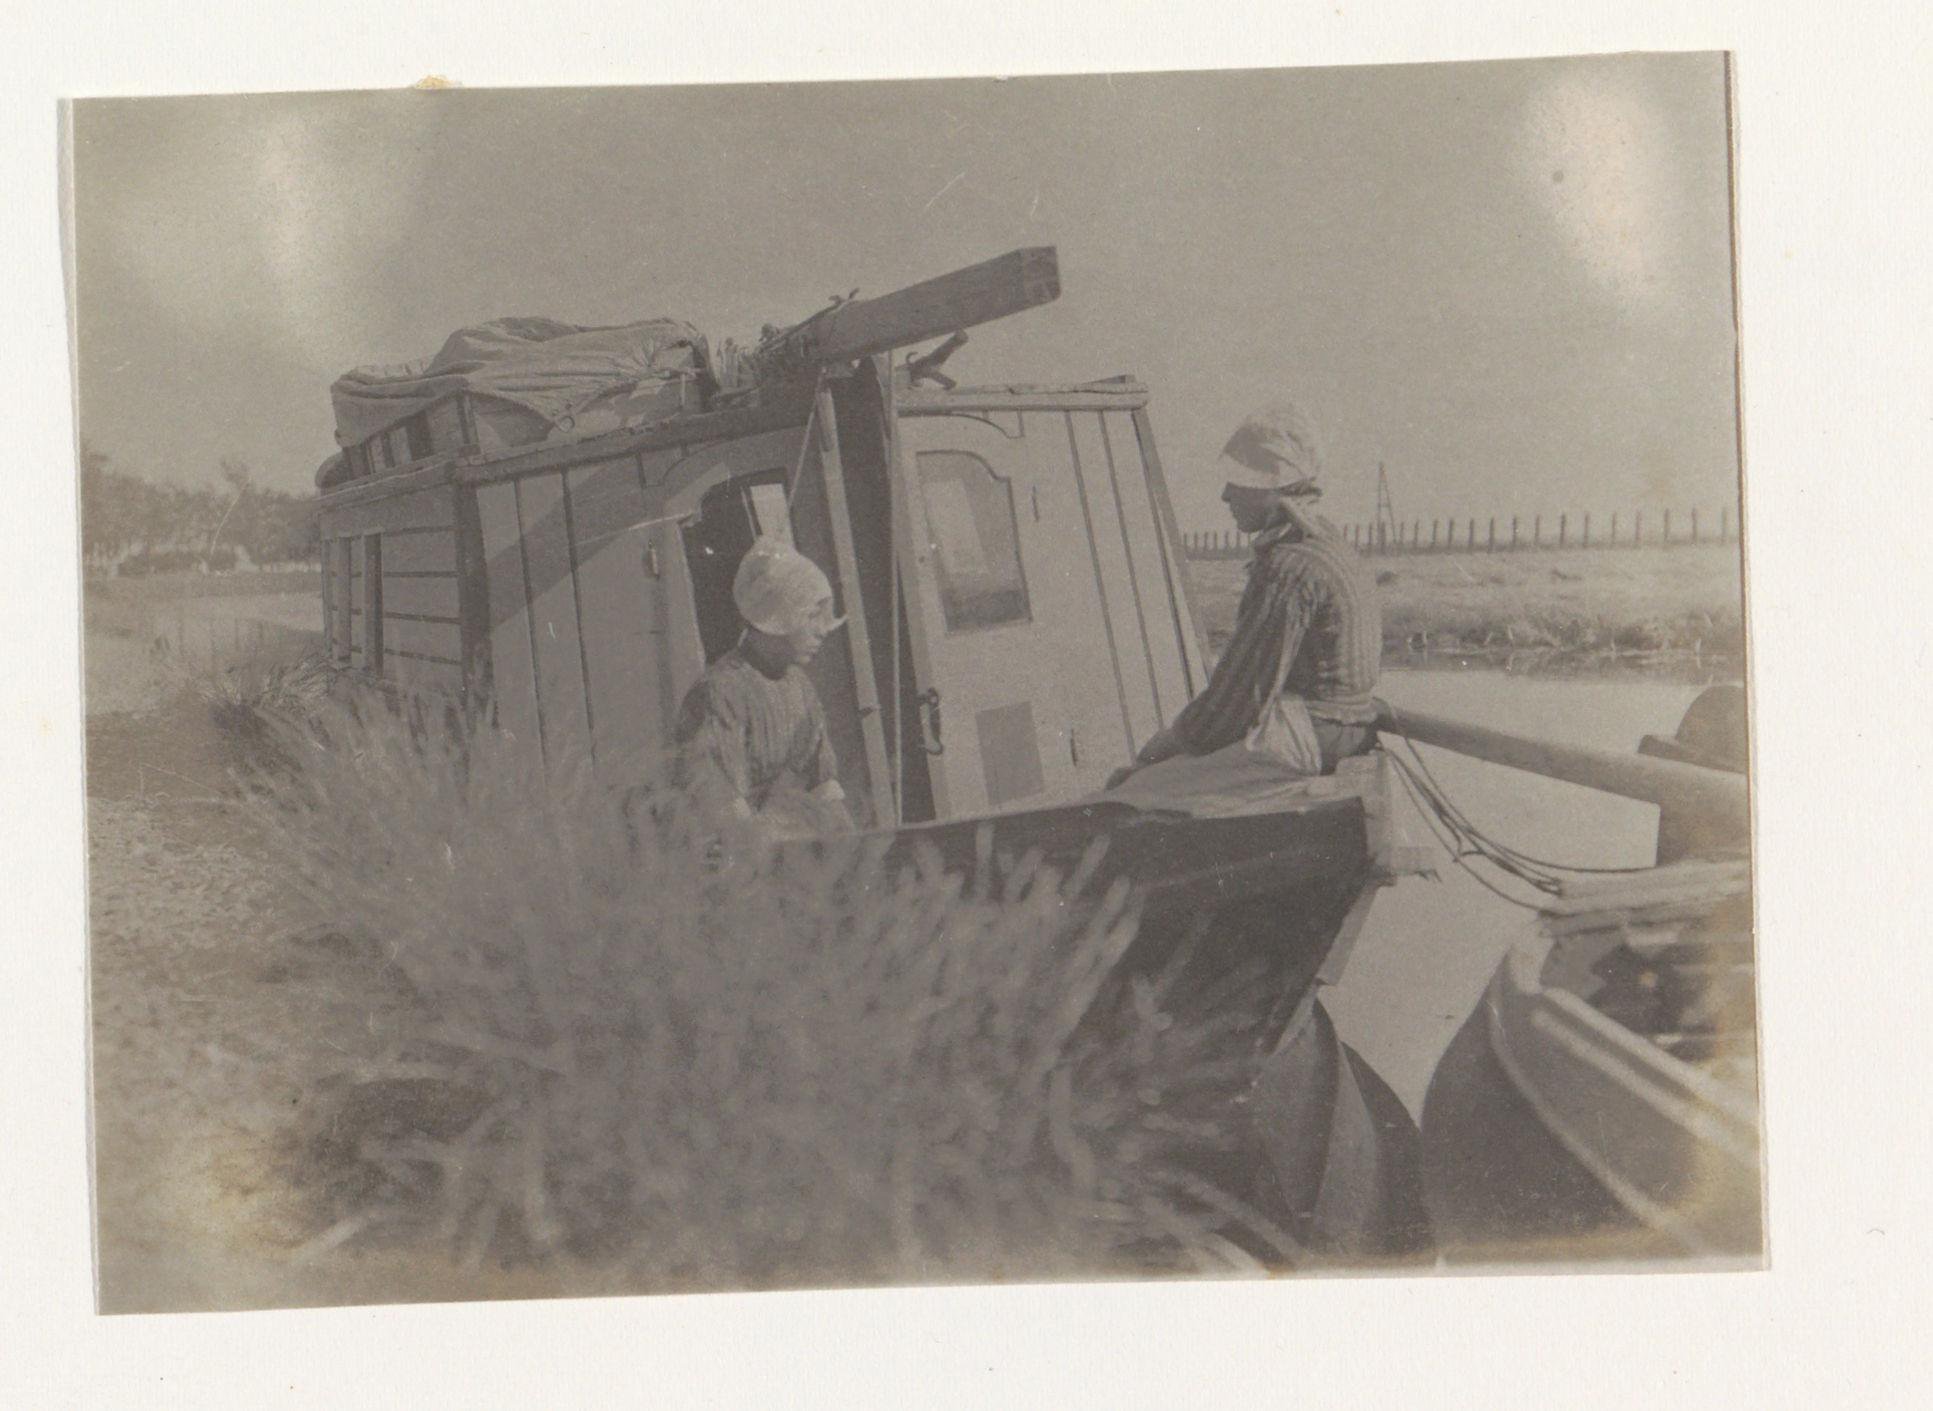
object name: photograph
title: Twee vrouwen in Volendamse klederdracht op een schuit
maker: george hidderley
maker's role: fotograaf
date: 1900-1910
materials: paper, photographic support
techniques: gelatin silver print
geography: volendam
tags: folk costume, regional costume (+ women's clothes), houseboat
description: Onderdeel van fotoalbum met opnames van Volendam, Dordrecht, Gorinchem en Woudrichem.